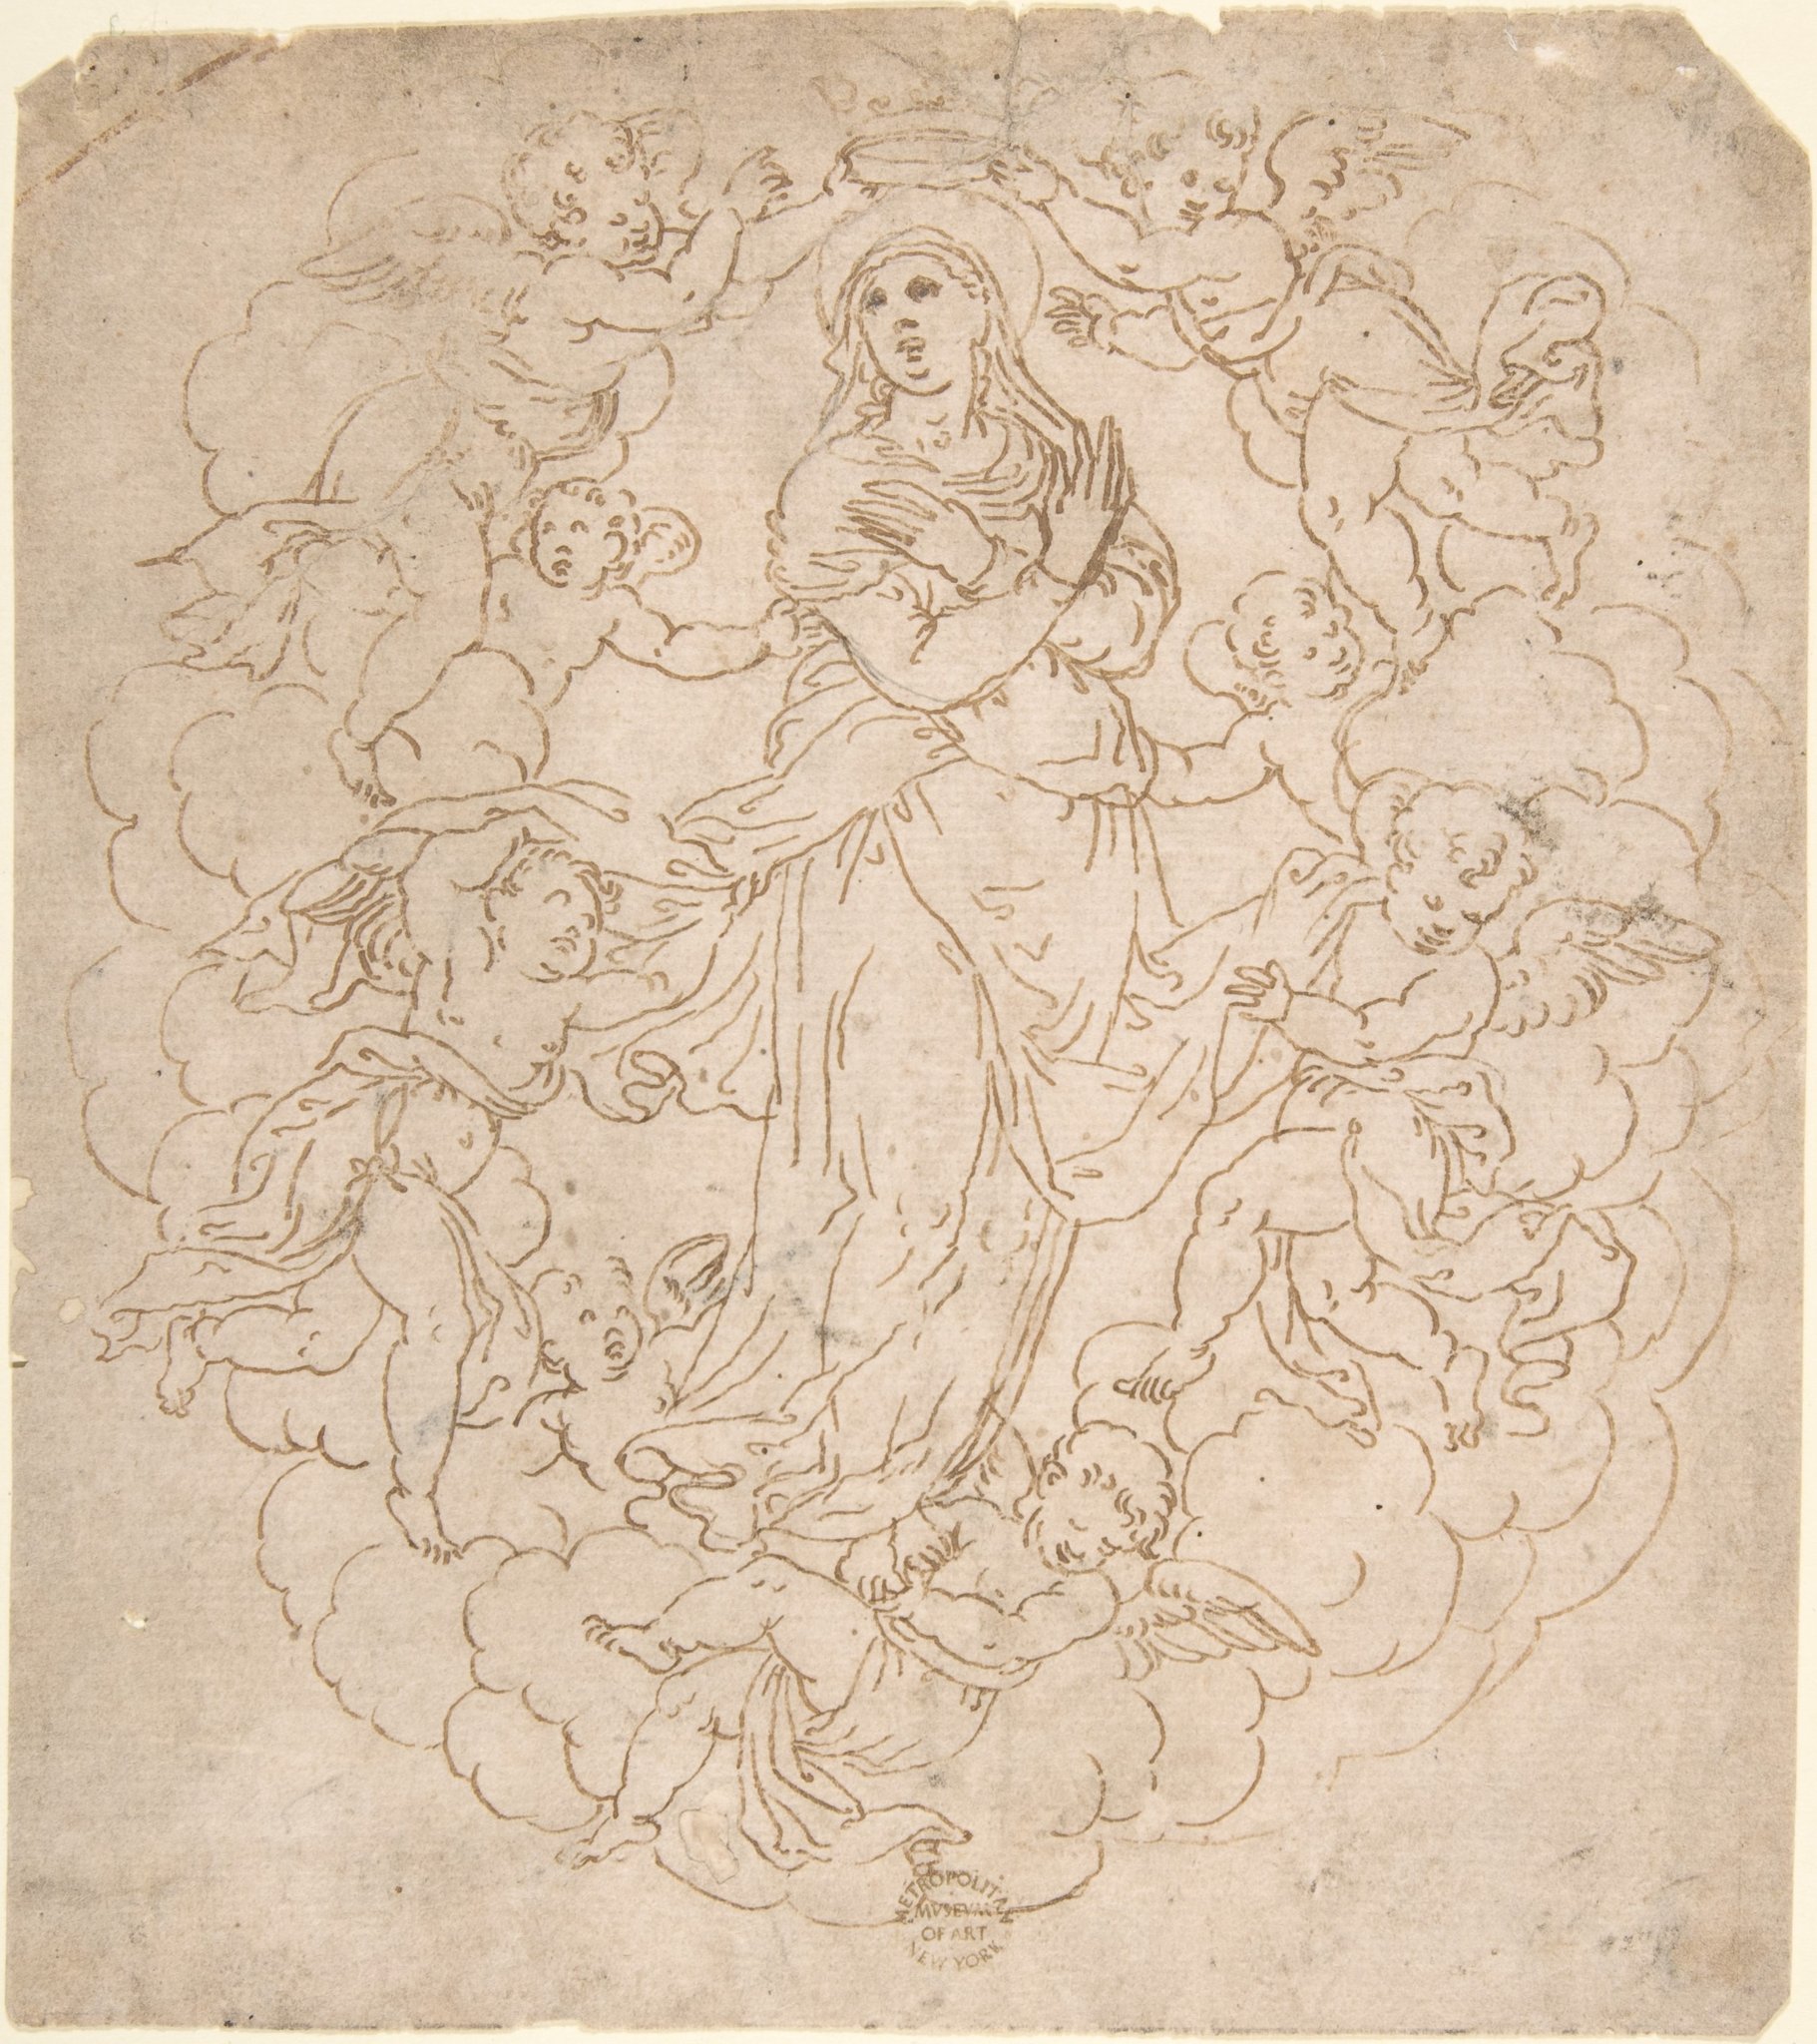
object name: drawing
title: Assumption of the Virgin (recto); Figure Sketches (verso)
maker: anonymous, italian, 16th century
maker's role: artist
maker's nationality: italian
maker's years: 1500-1600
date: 1501-1600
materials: chalk, graphite, ink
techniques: pen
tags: angels,virgin mary,assumption of the virgin